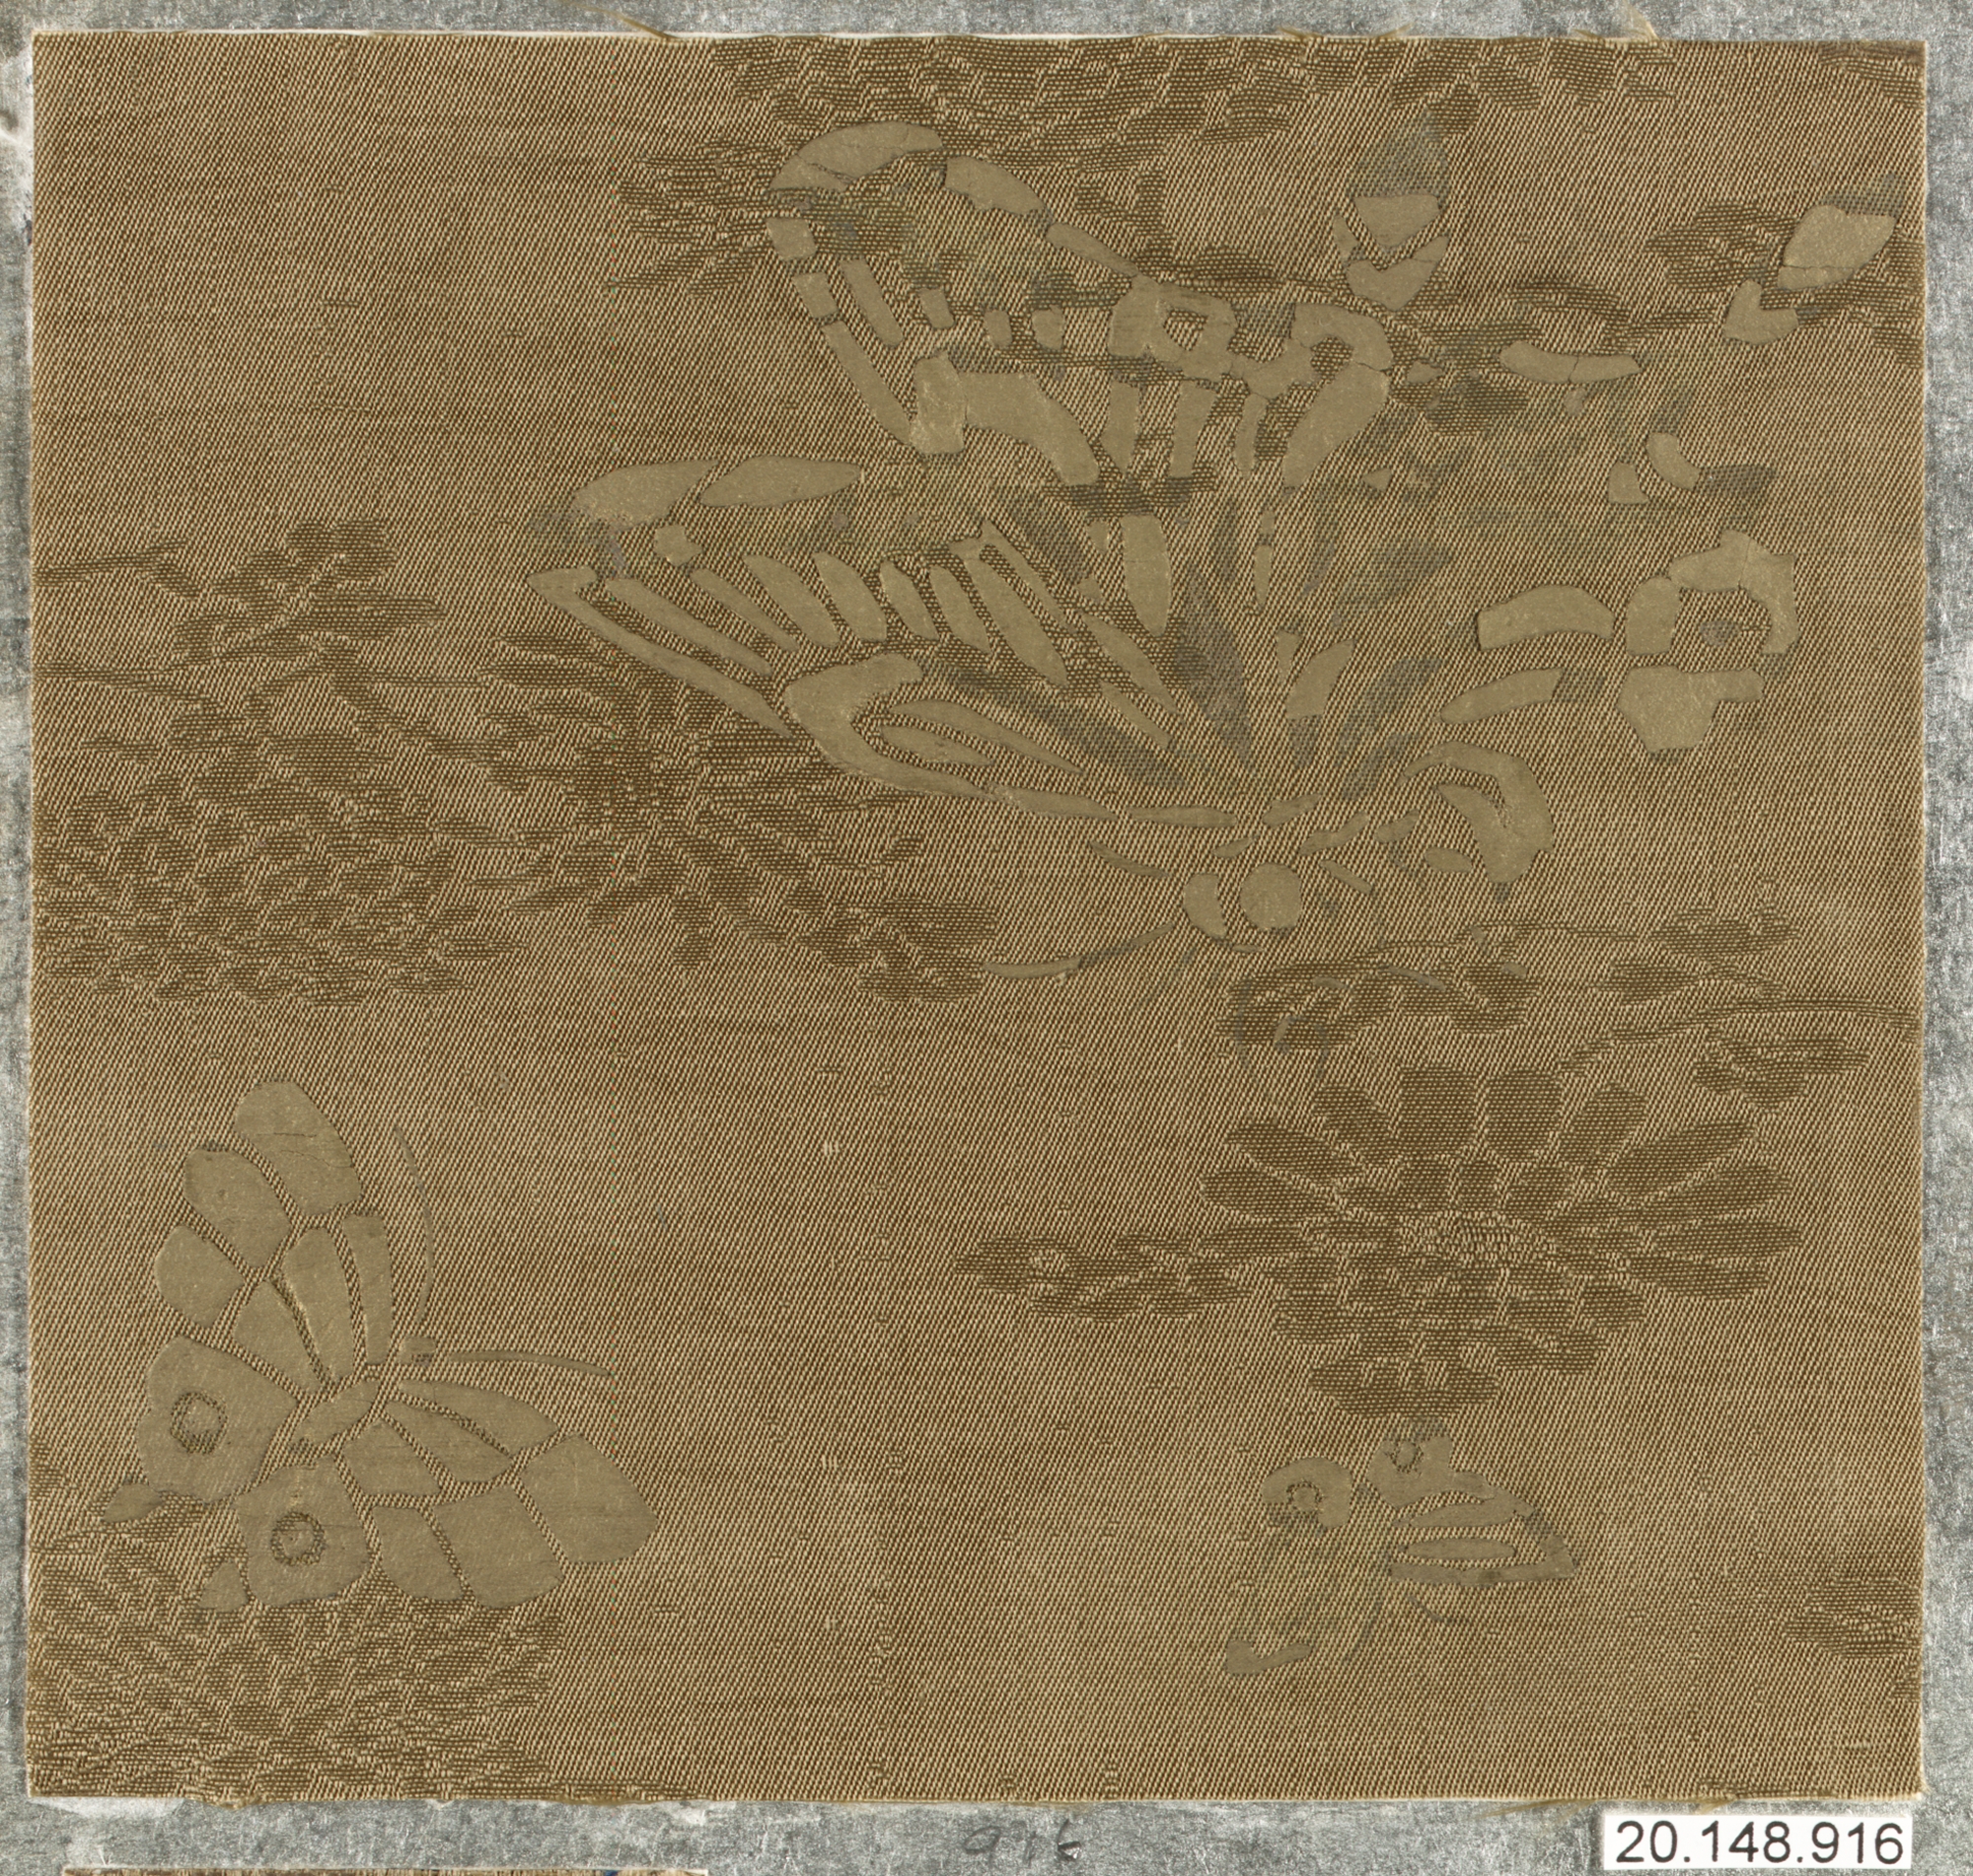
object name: piece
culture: japanese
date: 1601-1700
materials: silk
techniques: compound weave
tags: butterflies,flowers,leaves